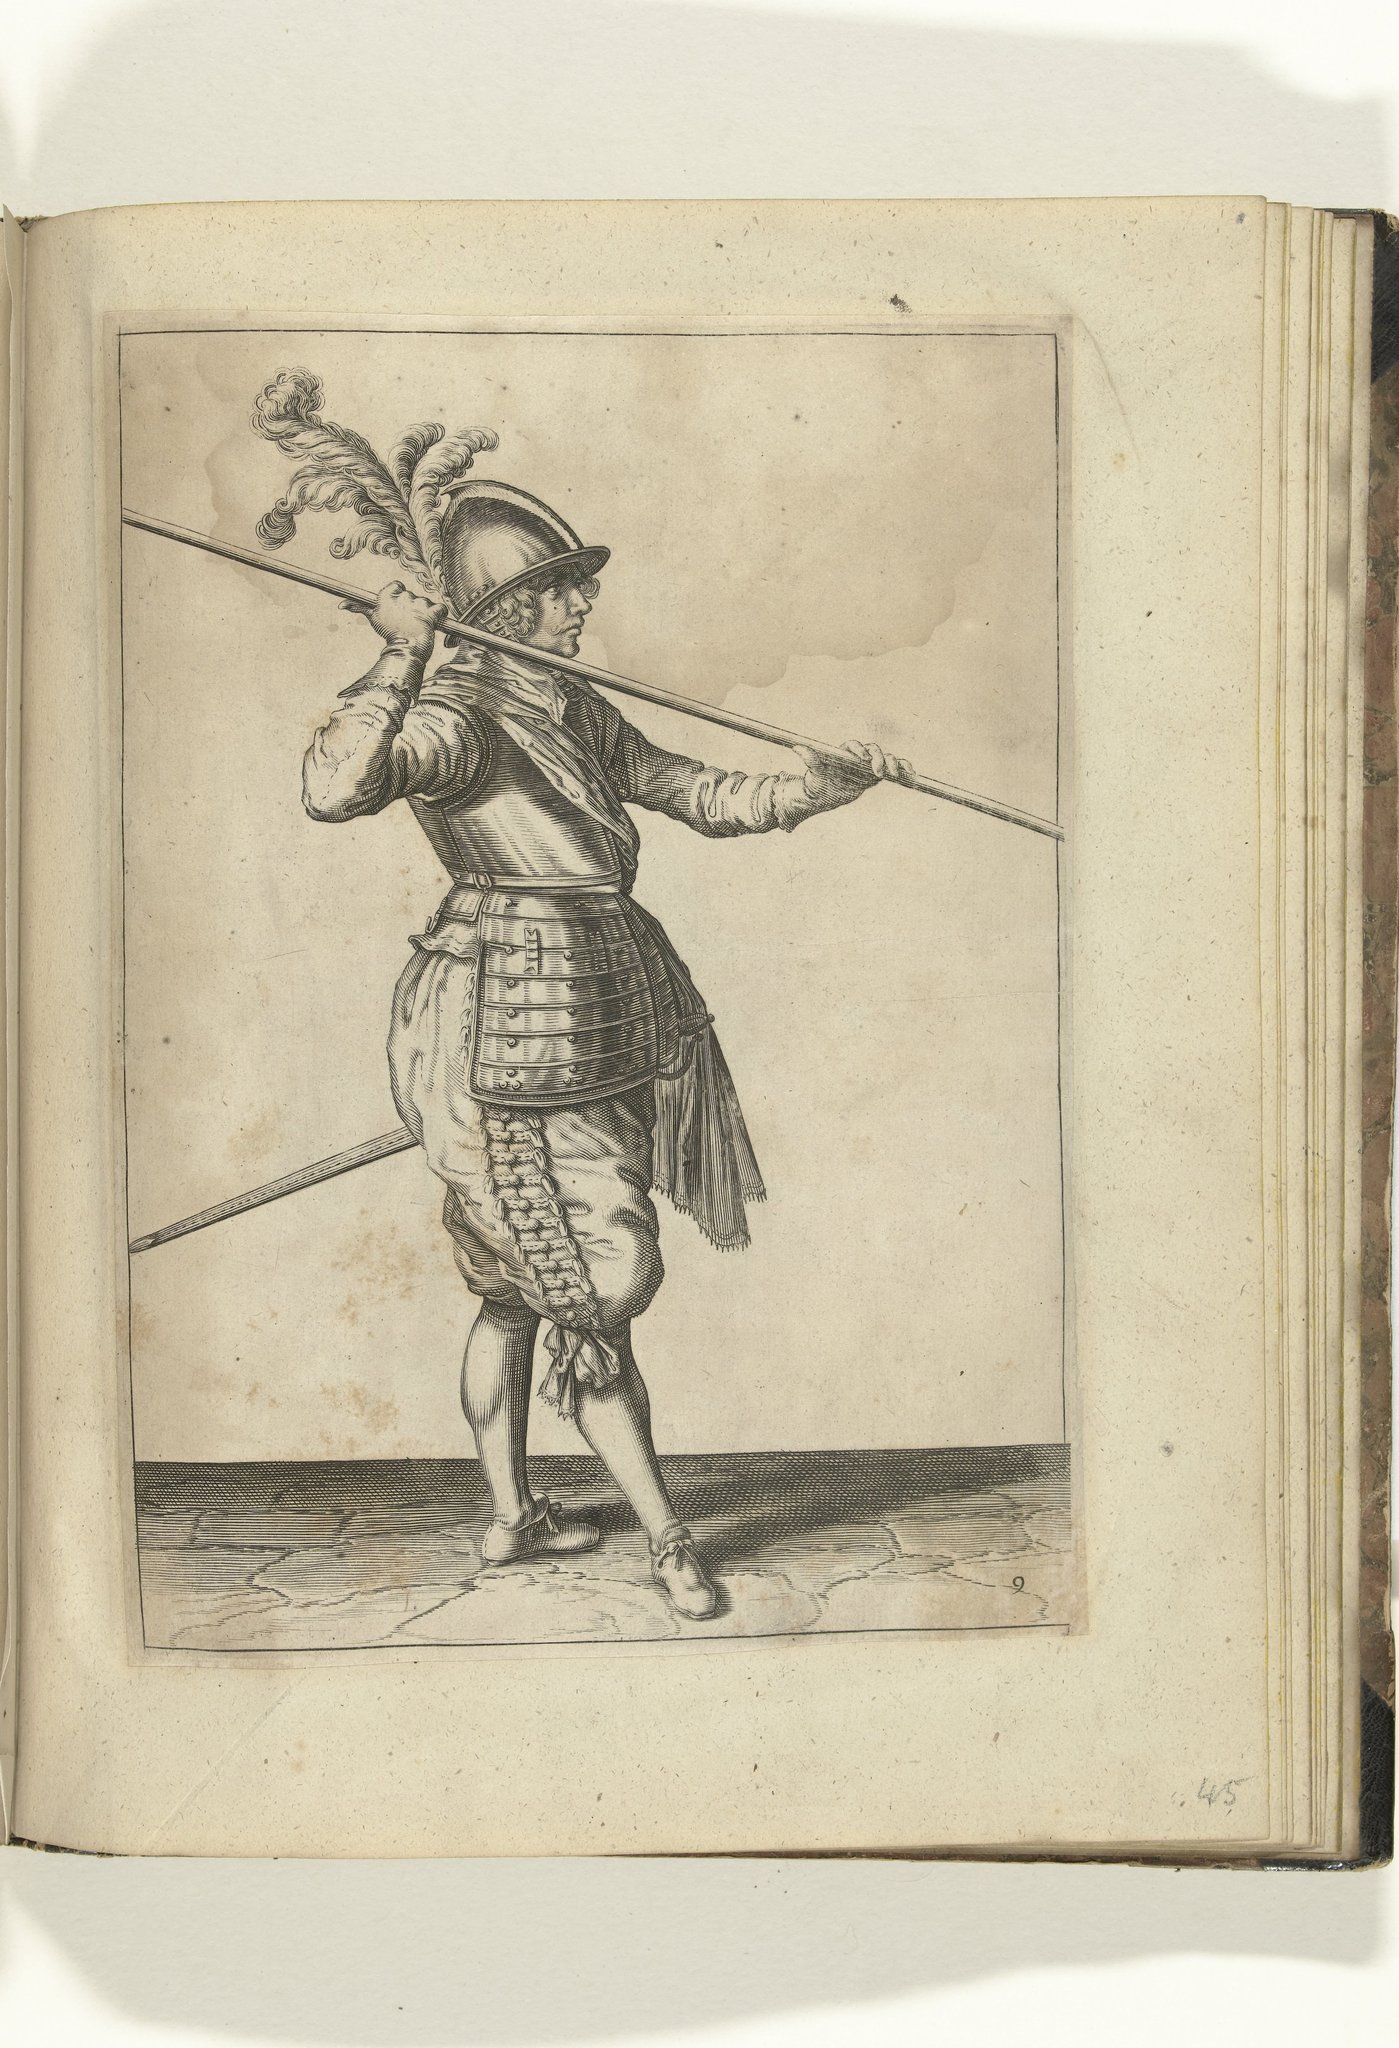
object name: print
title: Soldaat die zijn spies bijna horizontaal boven zijn rechterschouder draagt (nr. 9), ca. 1600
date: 1597-1608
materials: paper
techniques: engraving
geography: northern netherlands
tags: the hague, maurice (prince of orange), handling of weapons ~ military training, weapons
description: Een soldaat, ten voeten uit, naar rechts, die een spies (lans) bijna horizontaal boven zijn rechterschouder draagt (nr. 9), ca. 1600. Zijn handen ver uit elkaar om de spies. Dit is de tweede handeling voor het opheffen van de spies naar de schouder en het horizontaal dragen ervan. Plaat 9 in de instructies voor het hanteren van de spies: Brief instruction upon the contrefaictinges, concerning the right use, of all what a Souldier needeth to know in handling of the Pike. Onderdeel van de illustraties in een Engelse editie van J. de Gheyns Wapenhandelinghe: J. de Gheyn, The exercise of armes for calivres, muskettes and pikes after the ordre of Maurits Prince of Orange, 's-Gravenhage 1608. Krijgswezen rond 1600.